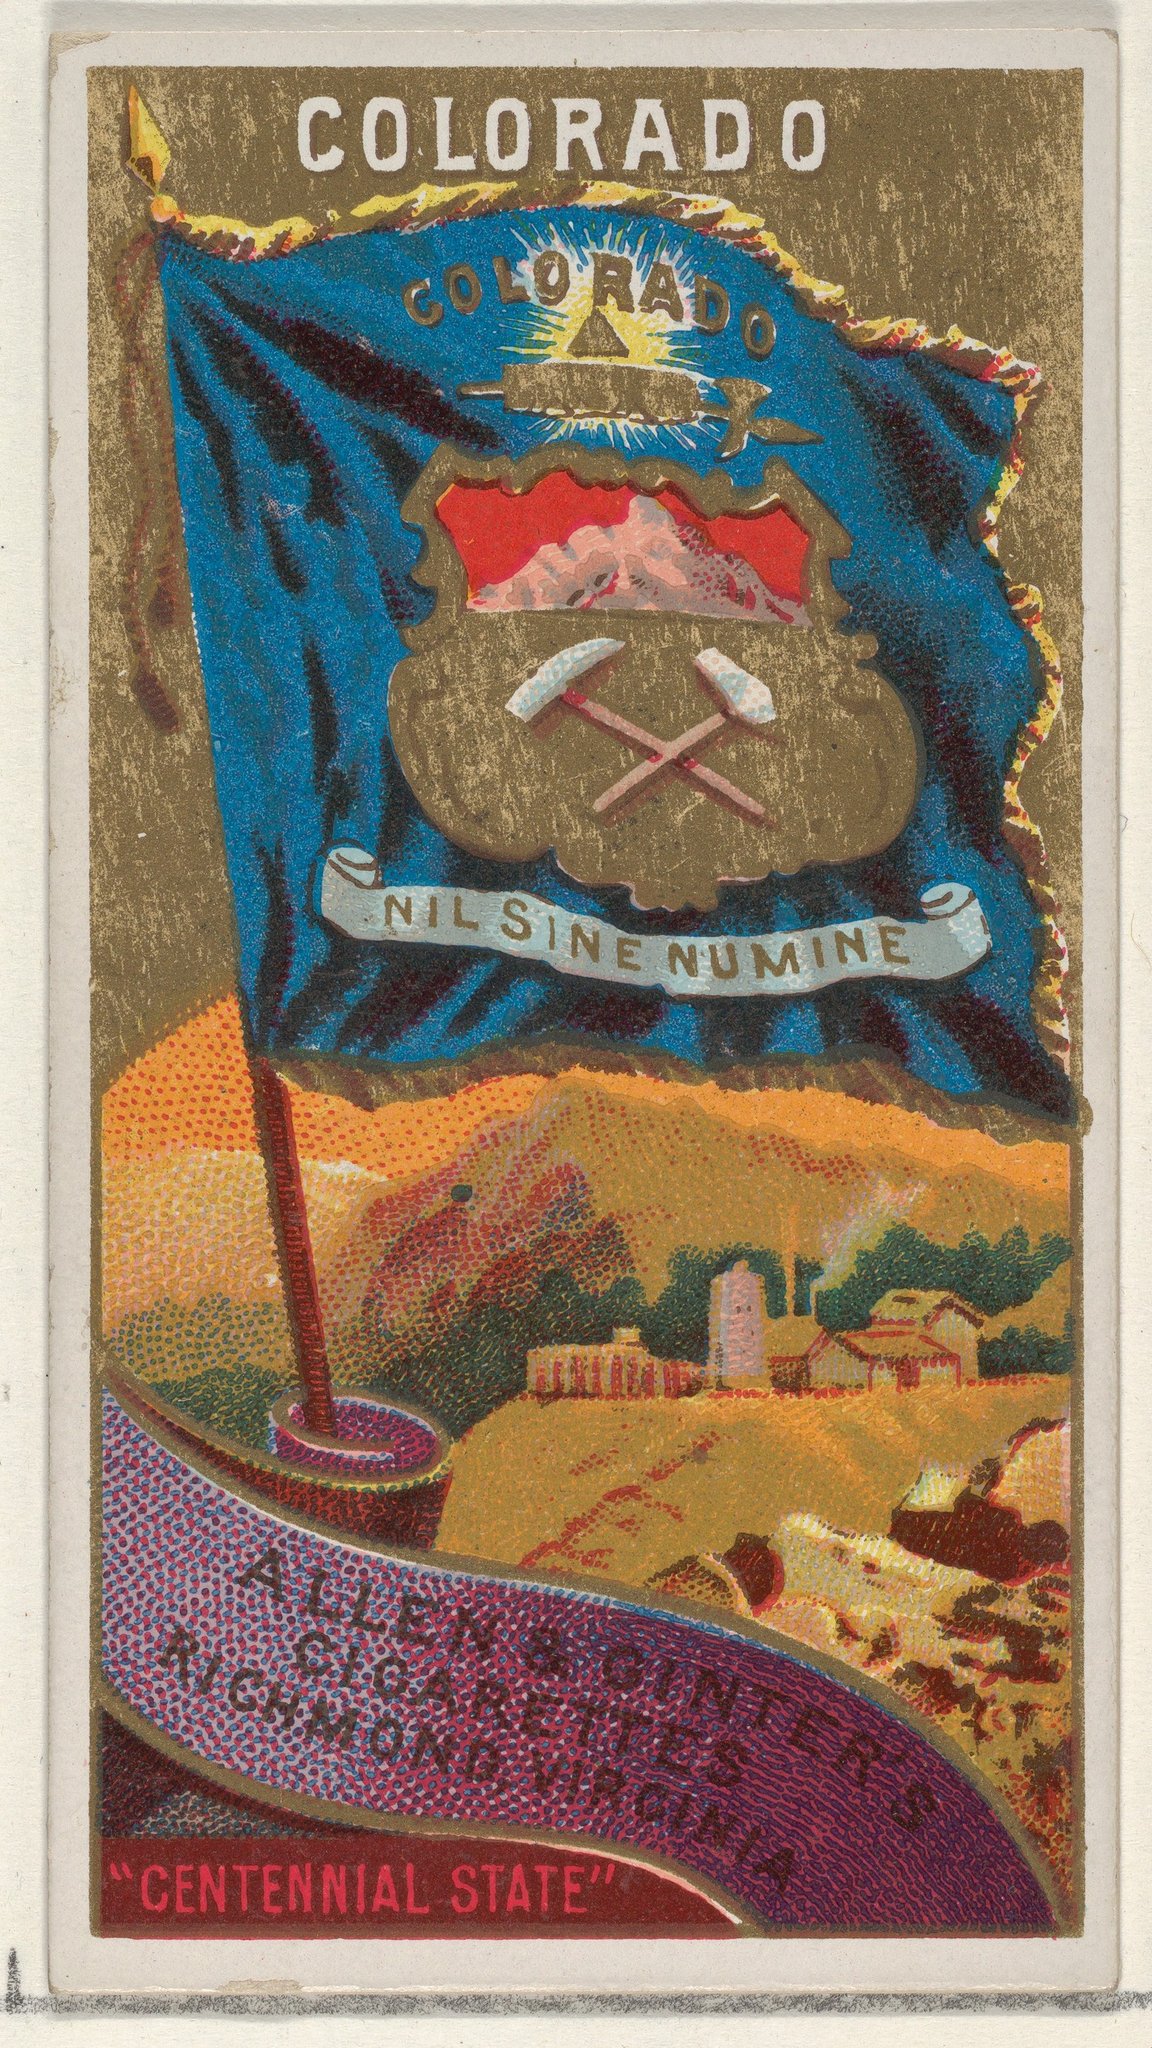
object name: print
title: Colorado, from Flags of the States and Territories (N11) for Allen & Ginter Cigarettes Brands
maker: allen & ginter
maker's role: publisher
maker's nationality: american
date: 1888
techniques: color lithograph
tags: coat of arms,flags